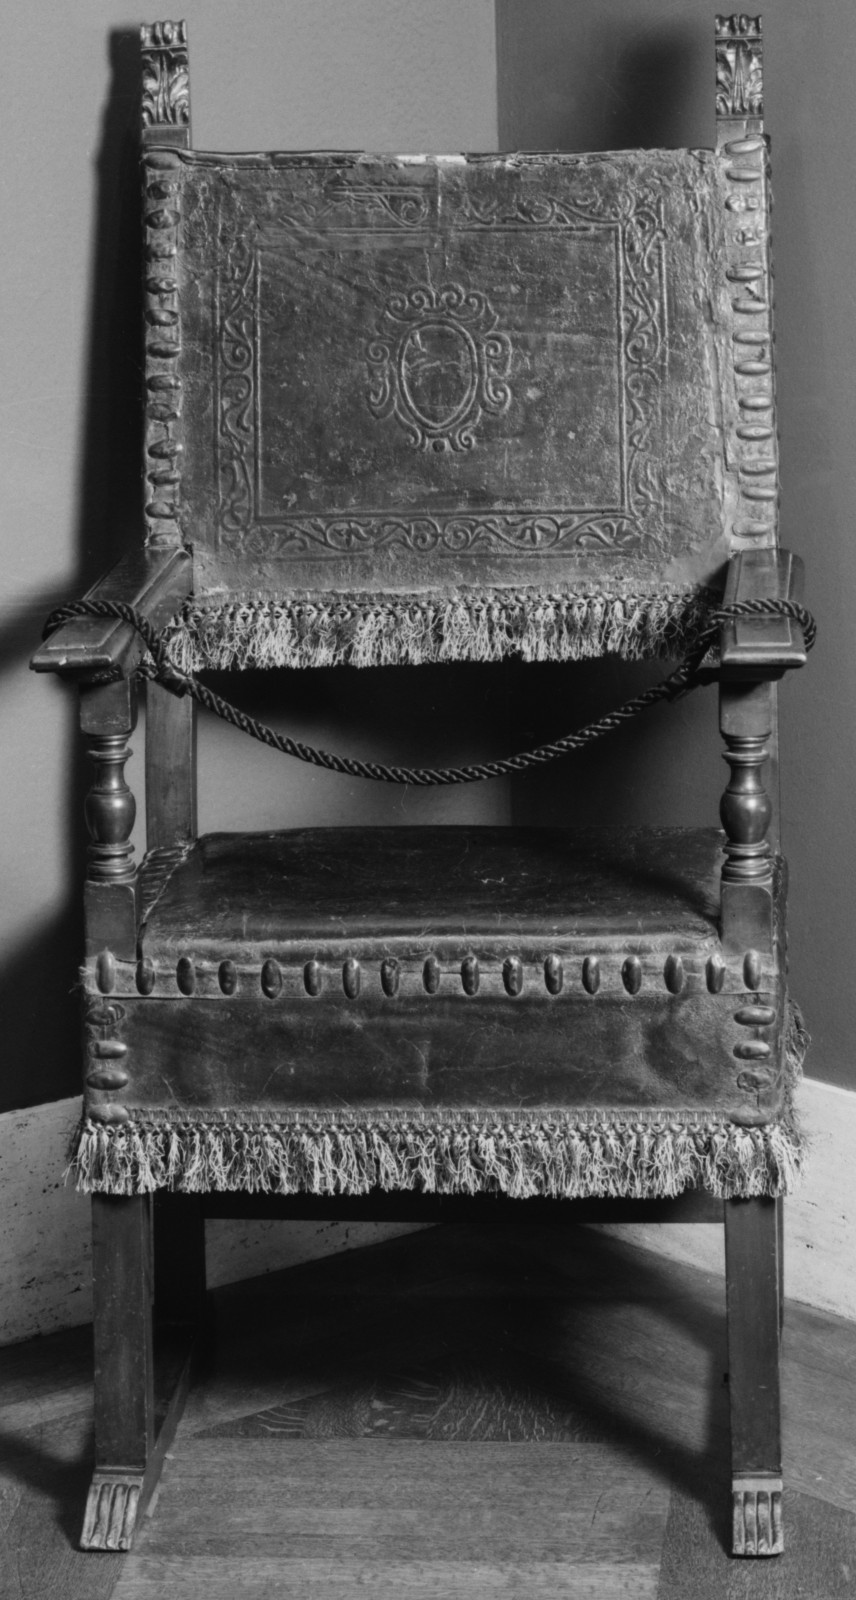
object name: armchair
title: Pair of armchairs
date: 1567-1700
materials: leather, wood